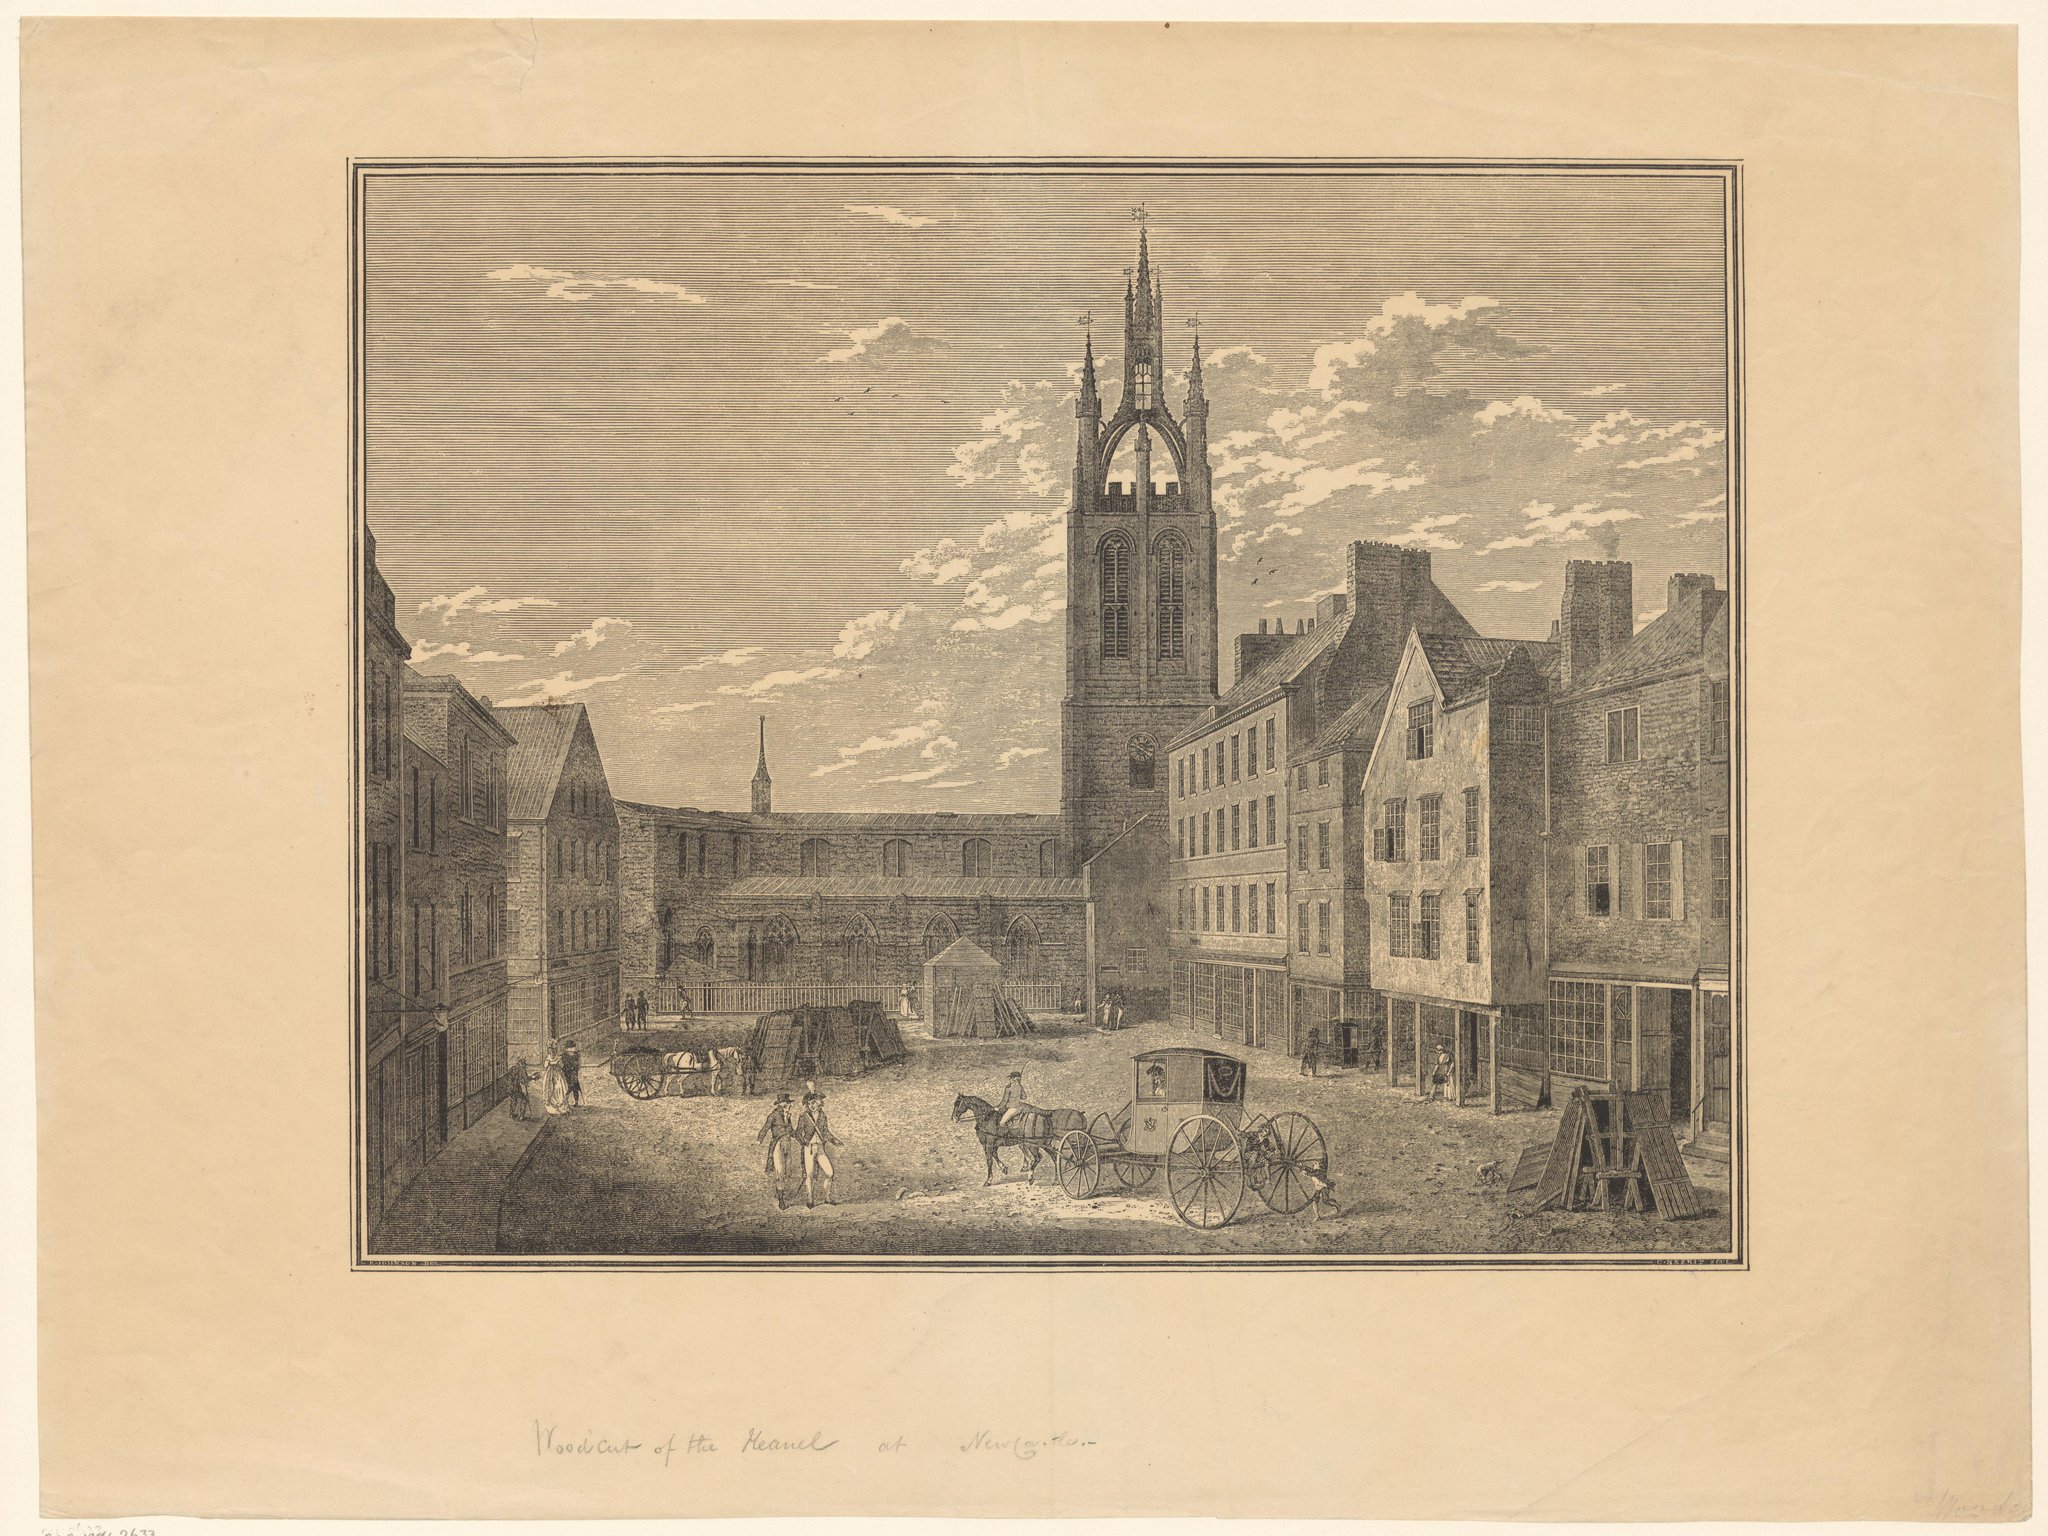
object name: print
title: Sint Nicolaaskathedraal te Newcastle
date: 1785-1838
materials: paper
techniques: engraving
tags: church (exterior), four-wheeled vehicle drawn by two animals, city-view, and landscape with man-made constructions (+ city(-scape) with figures, staffage)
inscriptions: collector's mark: Lugt 2228